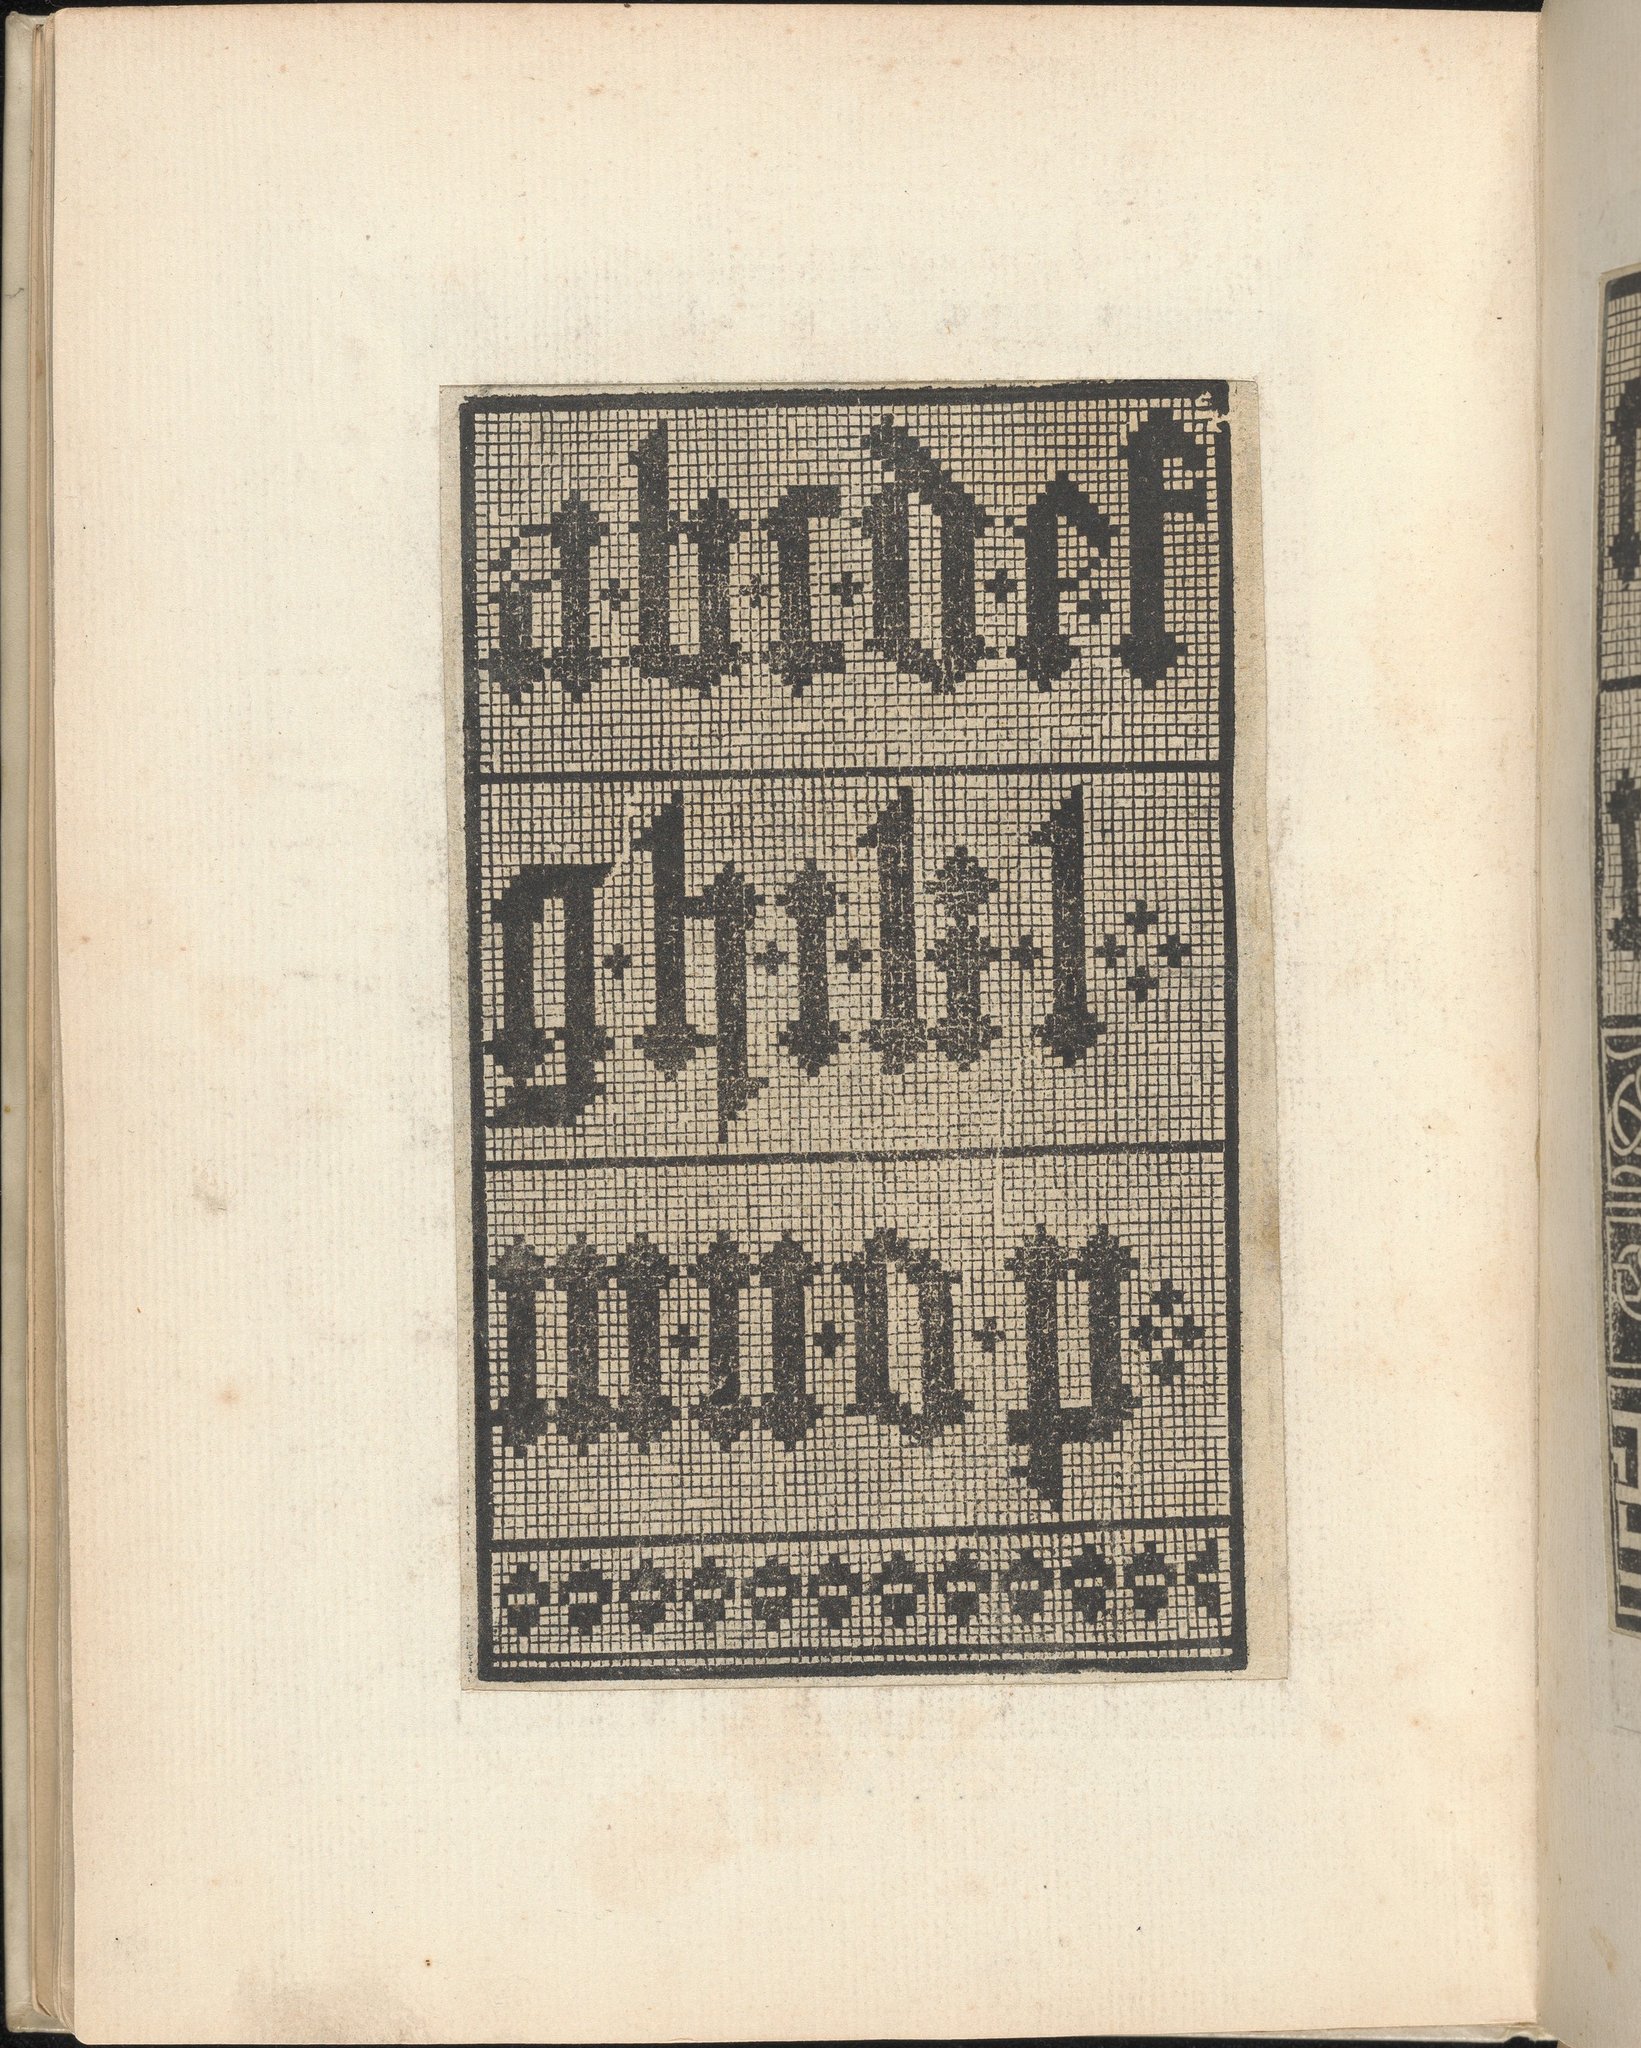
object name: book print ornament architecture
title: Esemplario di lavori, page 17 (recto)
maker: nicolò zoppino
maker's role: publisher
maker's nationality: italian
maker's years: 1478-1544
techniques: bookbinding, inlay, woodcut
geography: italy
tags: ornament